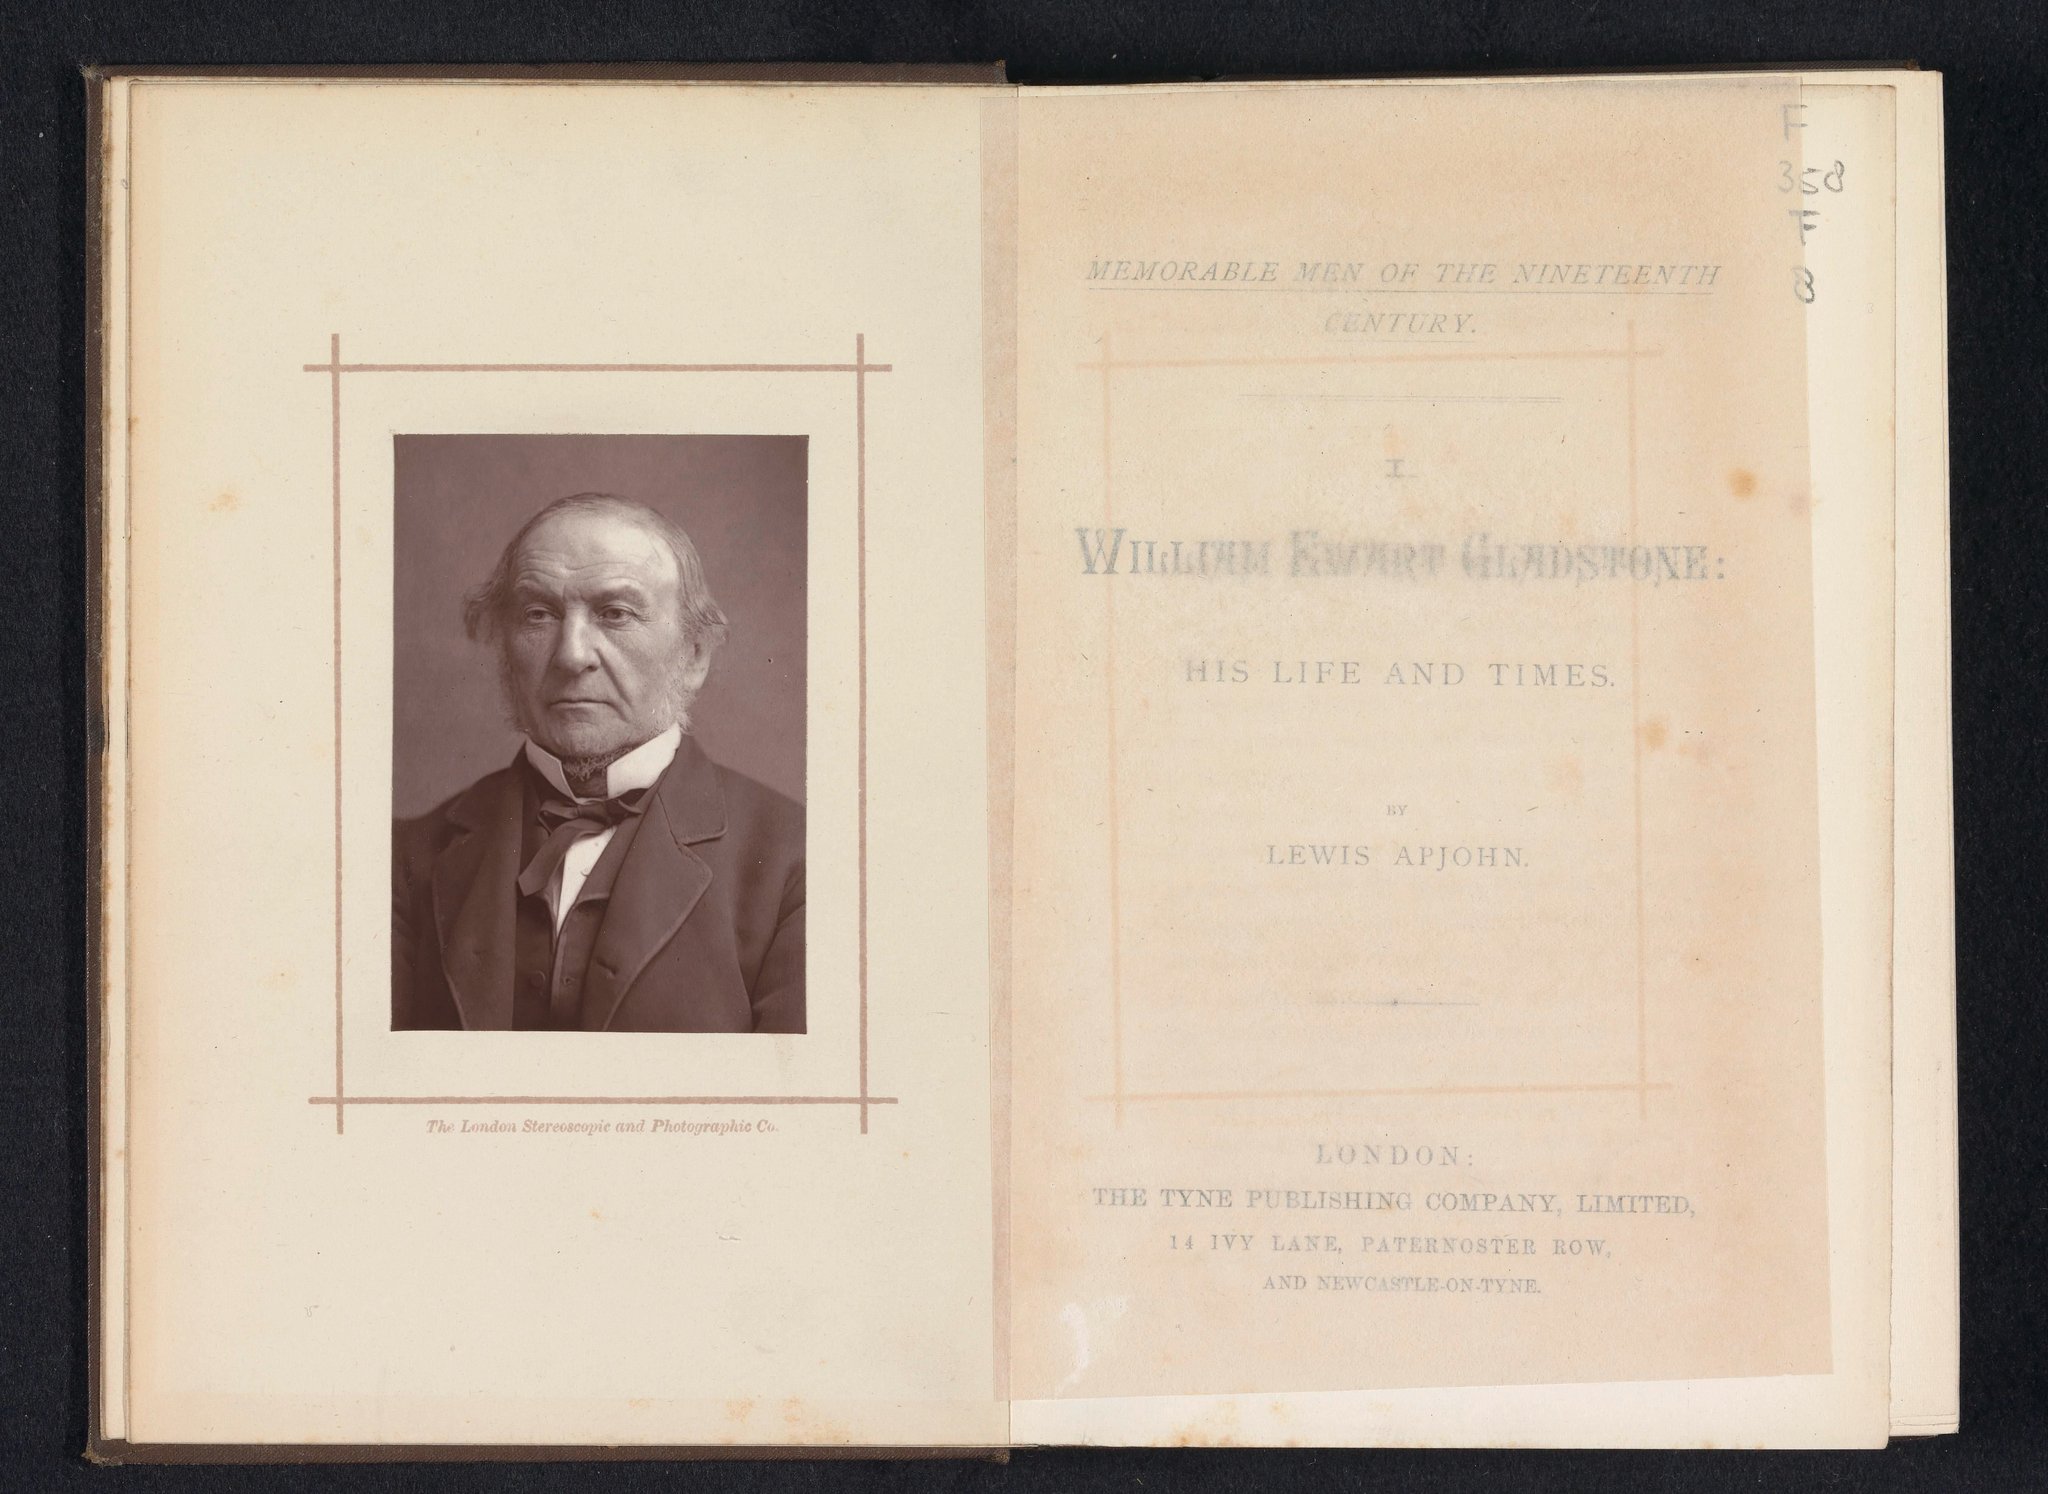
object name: photomechanical print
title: Portret van William Ewart Gladstone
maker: Anonymous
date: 1870-1880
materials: paper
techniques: woodburytype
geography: london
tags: liverpool, politician, adult man, politician, e.g. party leader